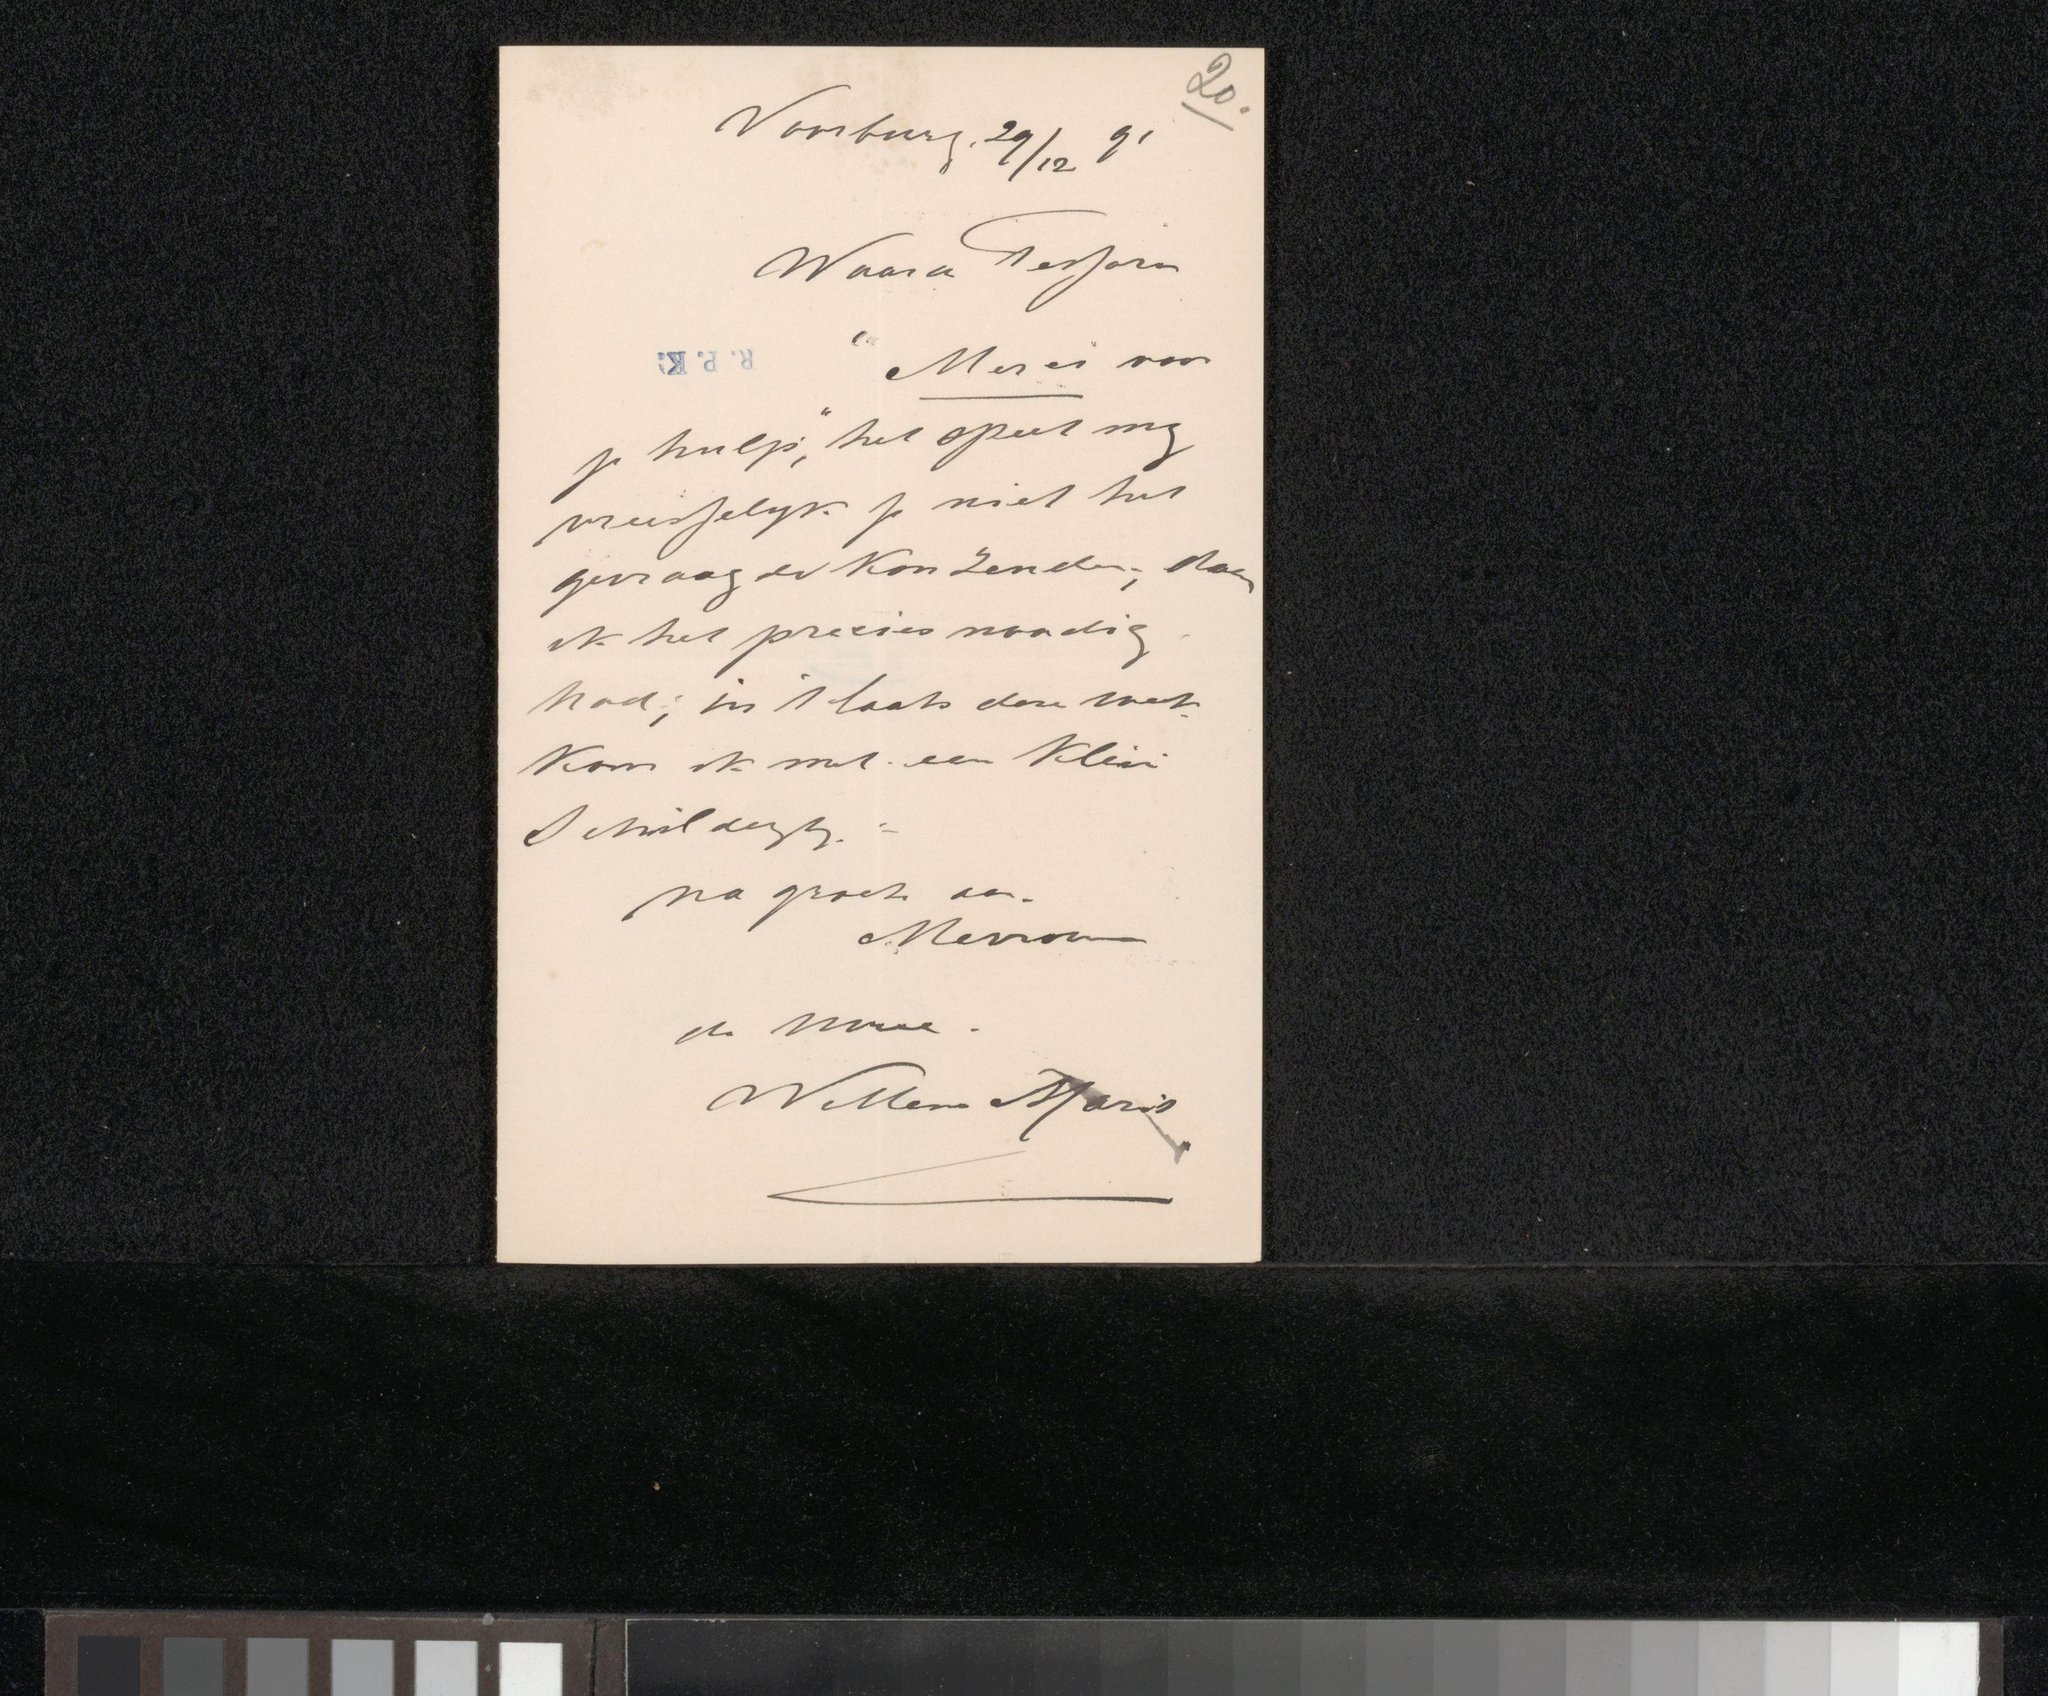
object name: letter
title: Brief aan Filippo Tessaro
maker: willem maris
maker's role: draughtsman, painter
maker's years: 1844-1910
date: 1891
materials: ink, paper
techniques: pen, writing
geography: voorburg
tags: amsterdam, art trade, art shop, painting (including book-illumination, miniature-painting)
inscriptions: collector's mark: Lugt 2233, collector's mark: Lugt 2228, watermark